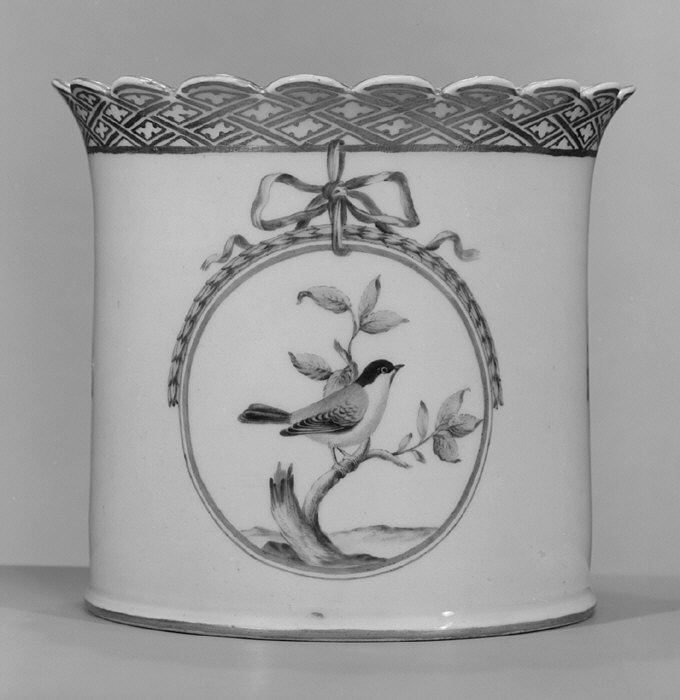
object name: bottle cooler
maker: imperial porcelain manufactory, st. petersburg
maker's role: manufactory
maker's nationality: russian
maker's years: 1744-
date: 1760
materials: hard paste porcelain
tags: birds,plants